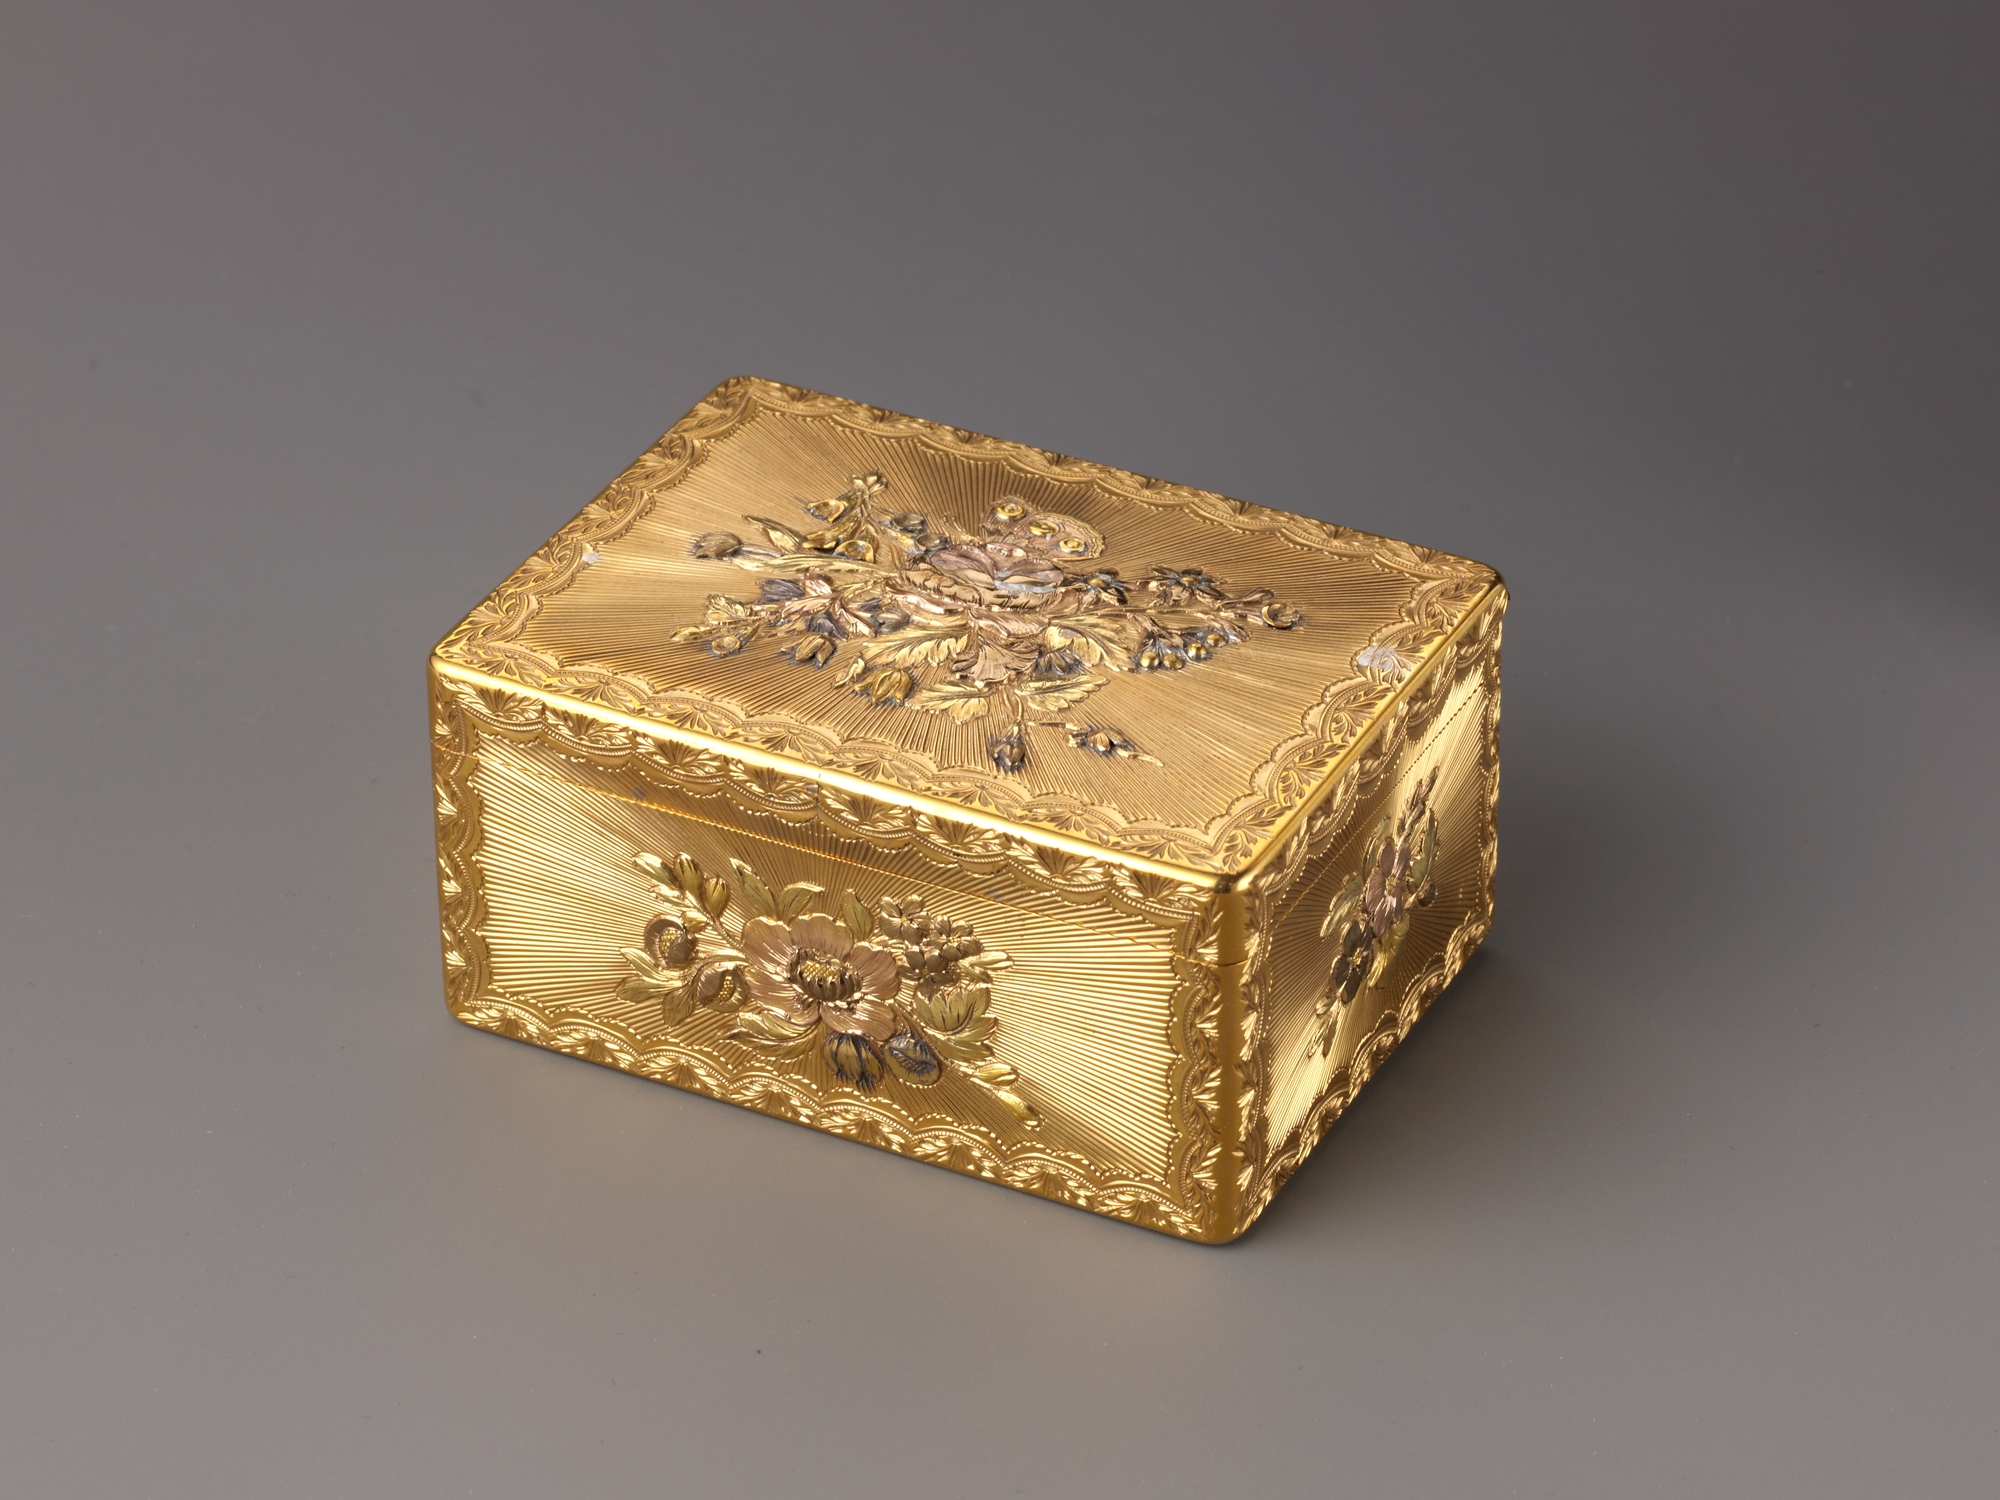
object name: snuffbox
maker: jean frémin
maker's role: artist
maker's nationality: french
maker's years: 1738-1786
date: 1755-1756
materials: gold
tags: flowers